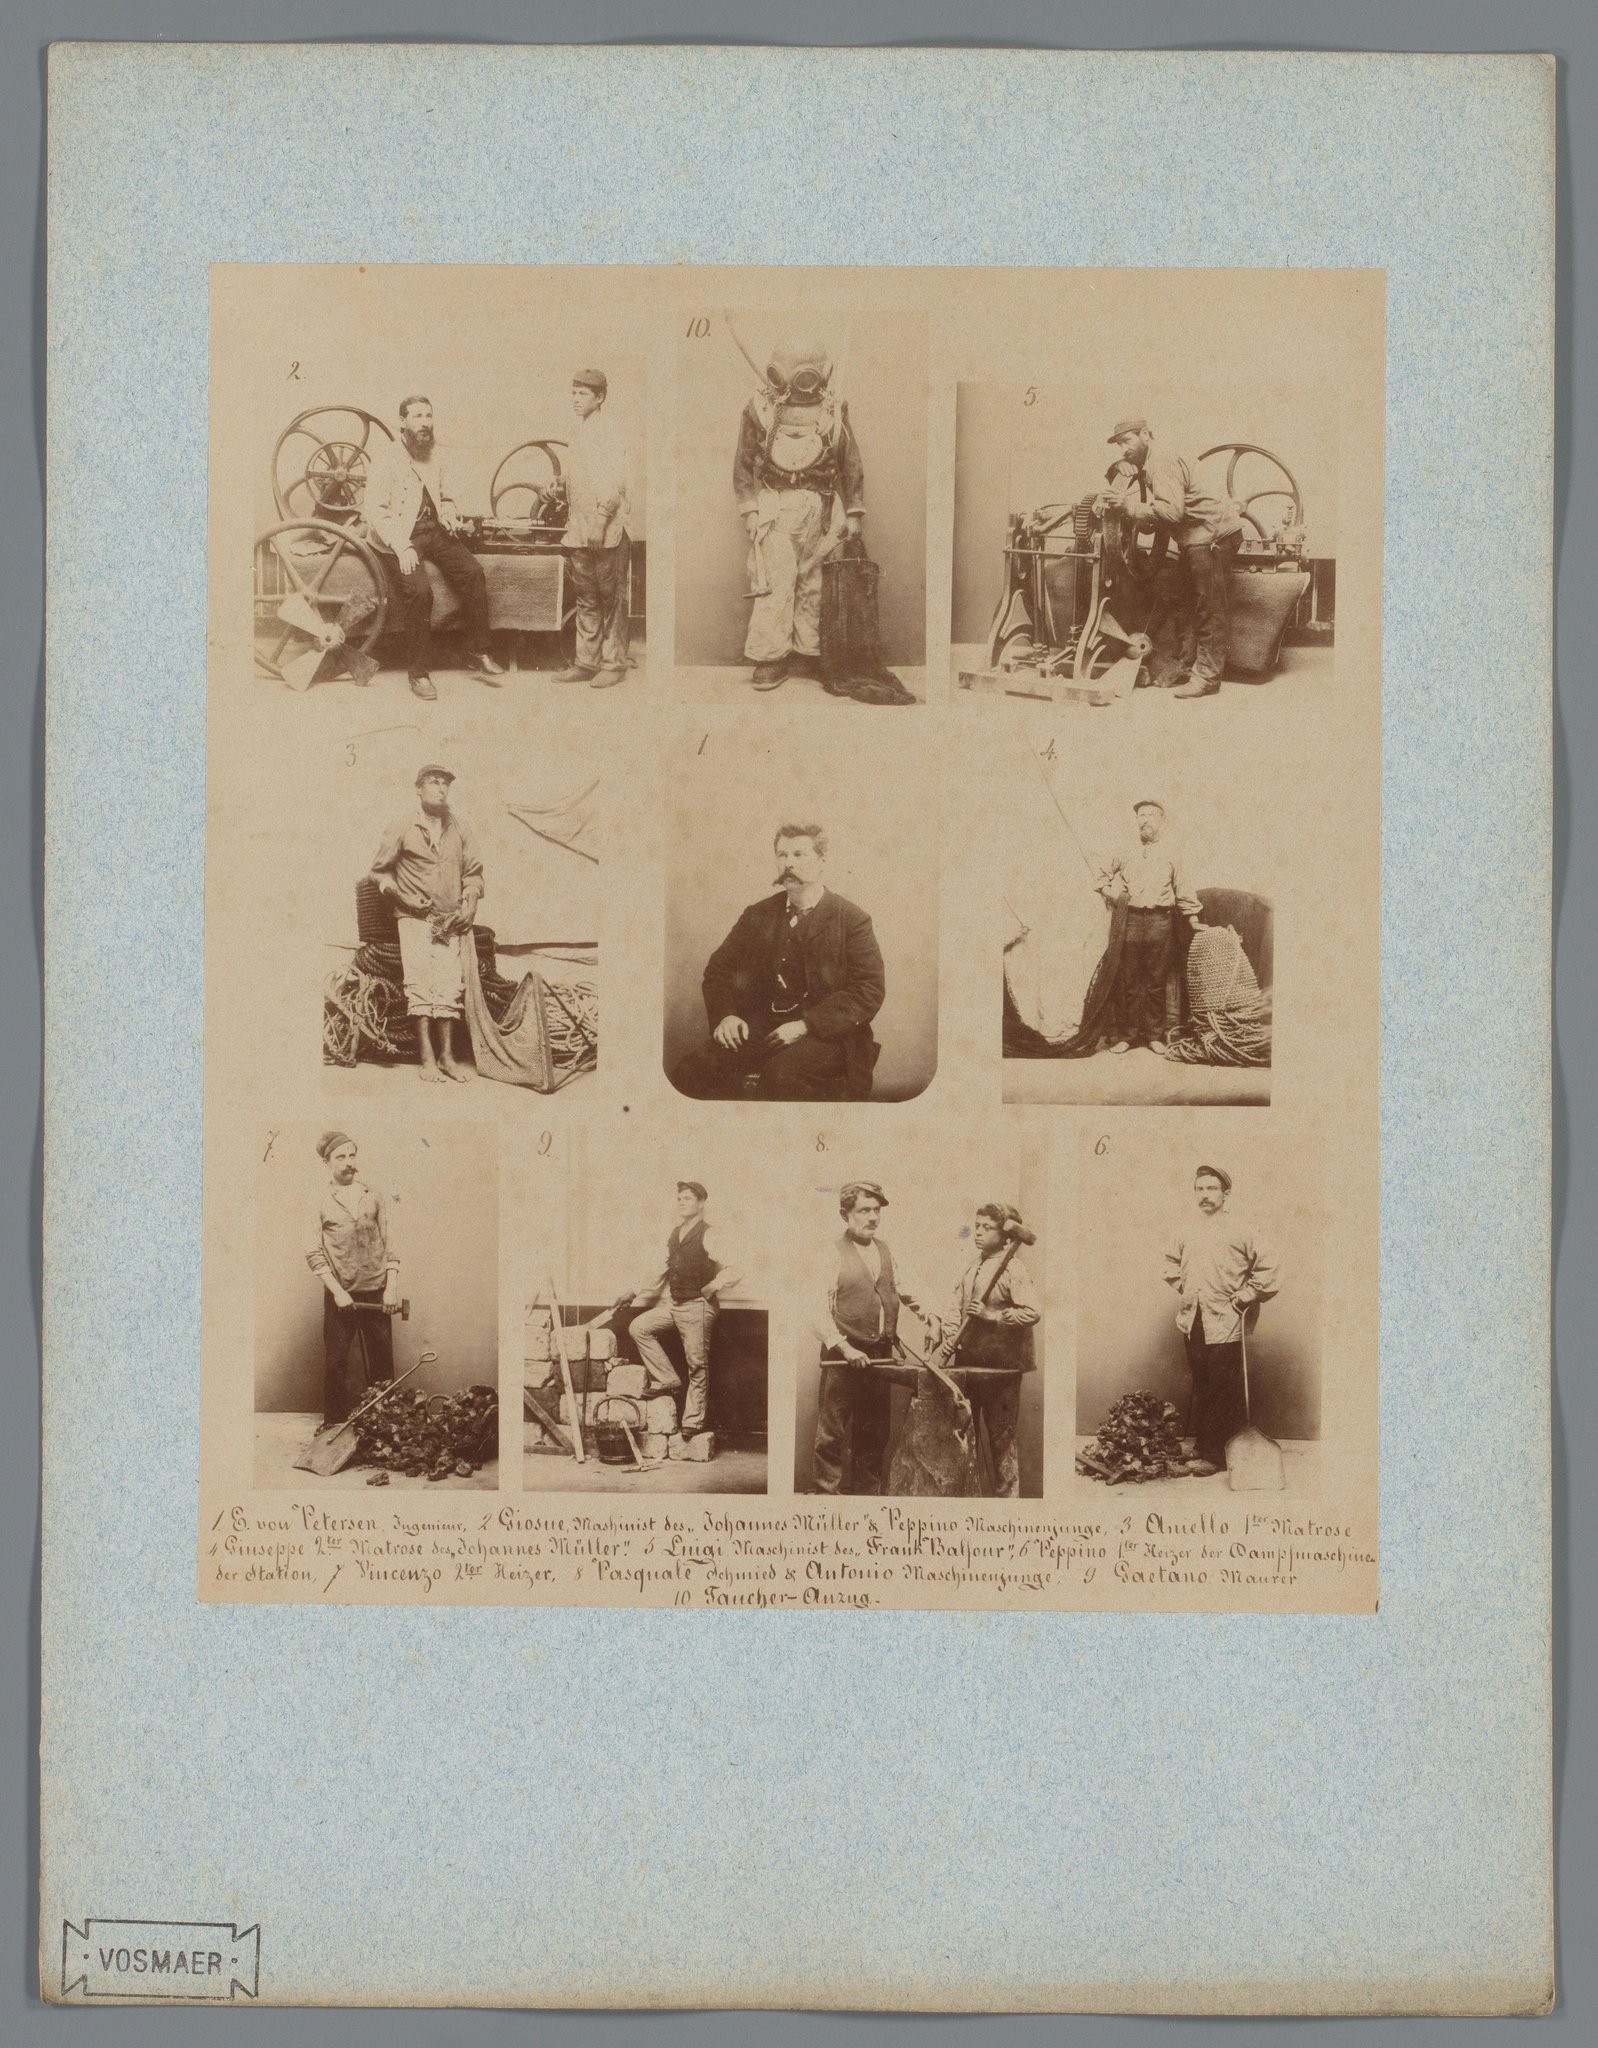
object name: photograph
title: Portretten van onbekende mannen met verschillende beroepen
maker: Anonymous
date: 1851-1900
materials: cardboard, paper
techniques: albumen print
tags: engineering, historical persons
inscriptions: collector's mark: ‘VOSMAER’, inscription: ‘1. E. von Petersen, Ingenieur, 2. Giosue, Mashinist des "Johannes Müller" & Peppino Maschinenjunge, 3 Aniello 1er Matrose/ "Giuseppe 2ter Matrose des "Johannes Müller." 5 Luigi Mschinist des "Frank Bassour", 6 Peppino 1er Heizer der Dampfmaschine/ der Station, 7. Vincenzo 2er Heizer 8 Pasquale Schmid & Antonio Maschinenjunge, 9 Paetano Maurer/ 10 Taucher-Anzug.’